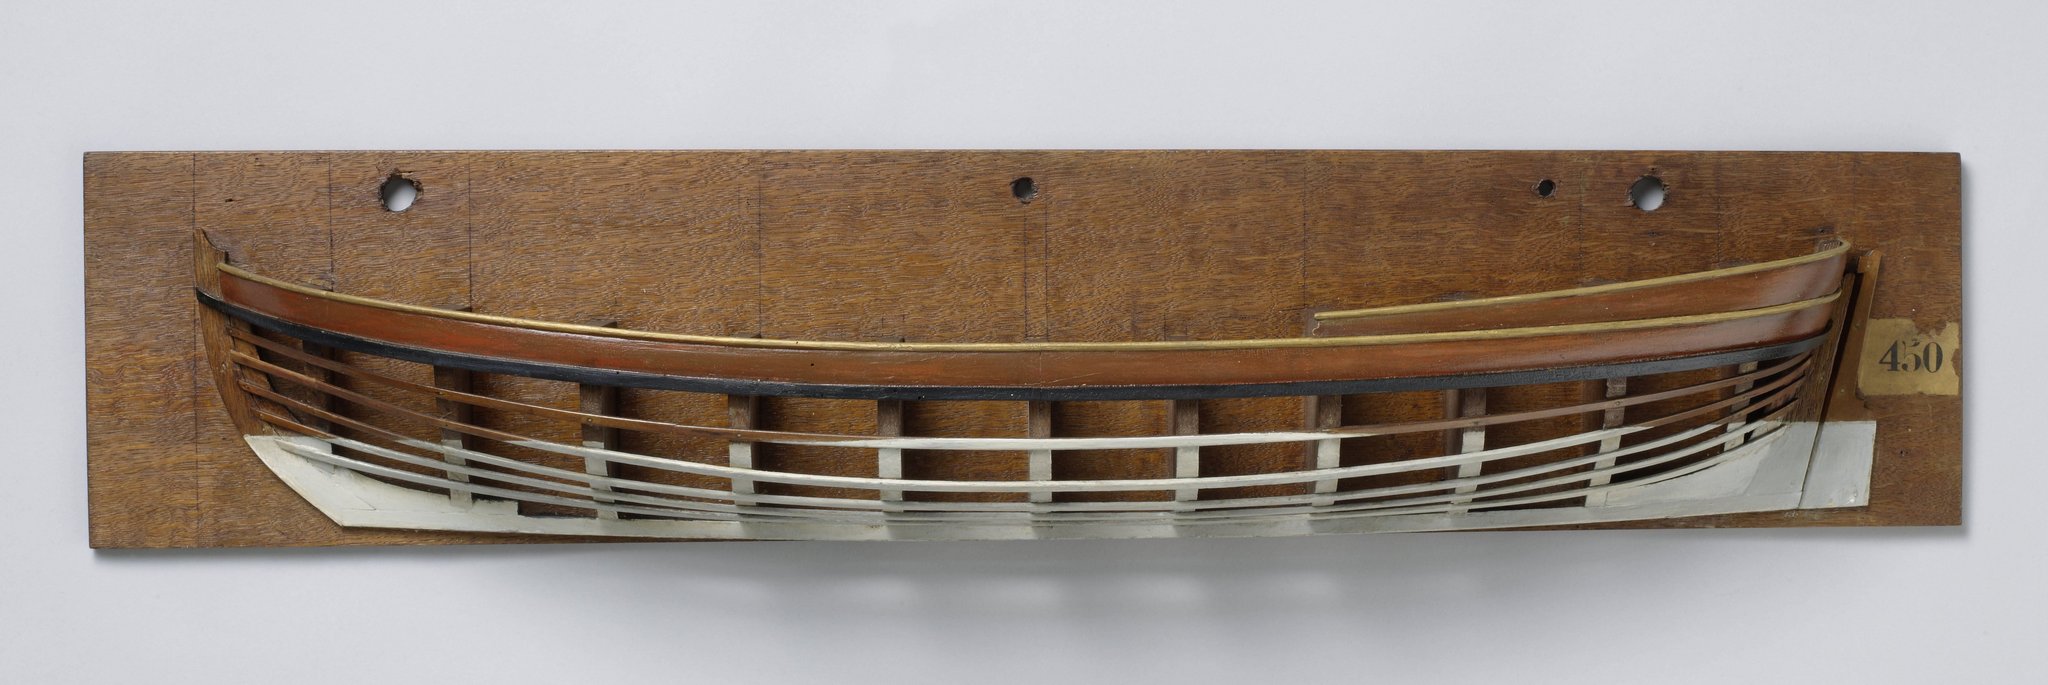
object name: ship model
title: Half Model of a Launch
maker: Anonymous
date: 1780-1820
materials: wood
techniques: polychromy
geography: netherlands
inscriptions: label, bottom right: ‘450’ former inventory label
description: Gepolychromeerd mallenmodel (bakboord) van een sloep. Het boeisel boven het barkhout is gesloten en achterin verhoogd met een gilling. Rond achterwerk, breed roer. De zeeg loopt op naar beide uiteinden, één barkhout. Gepiekt rondspant.